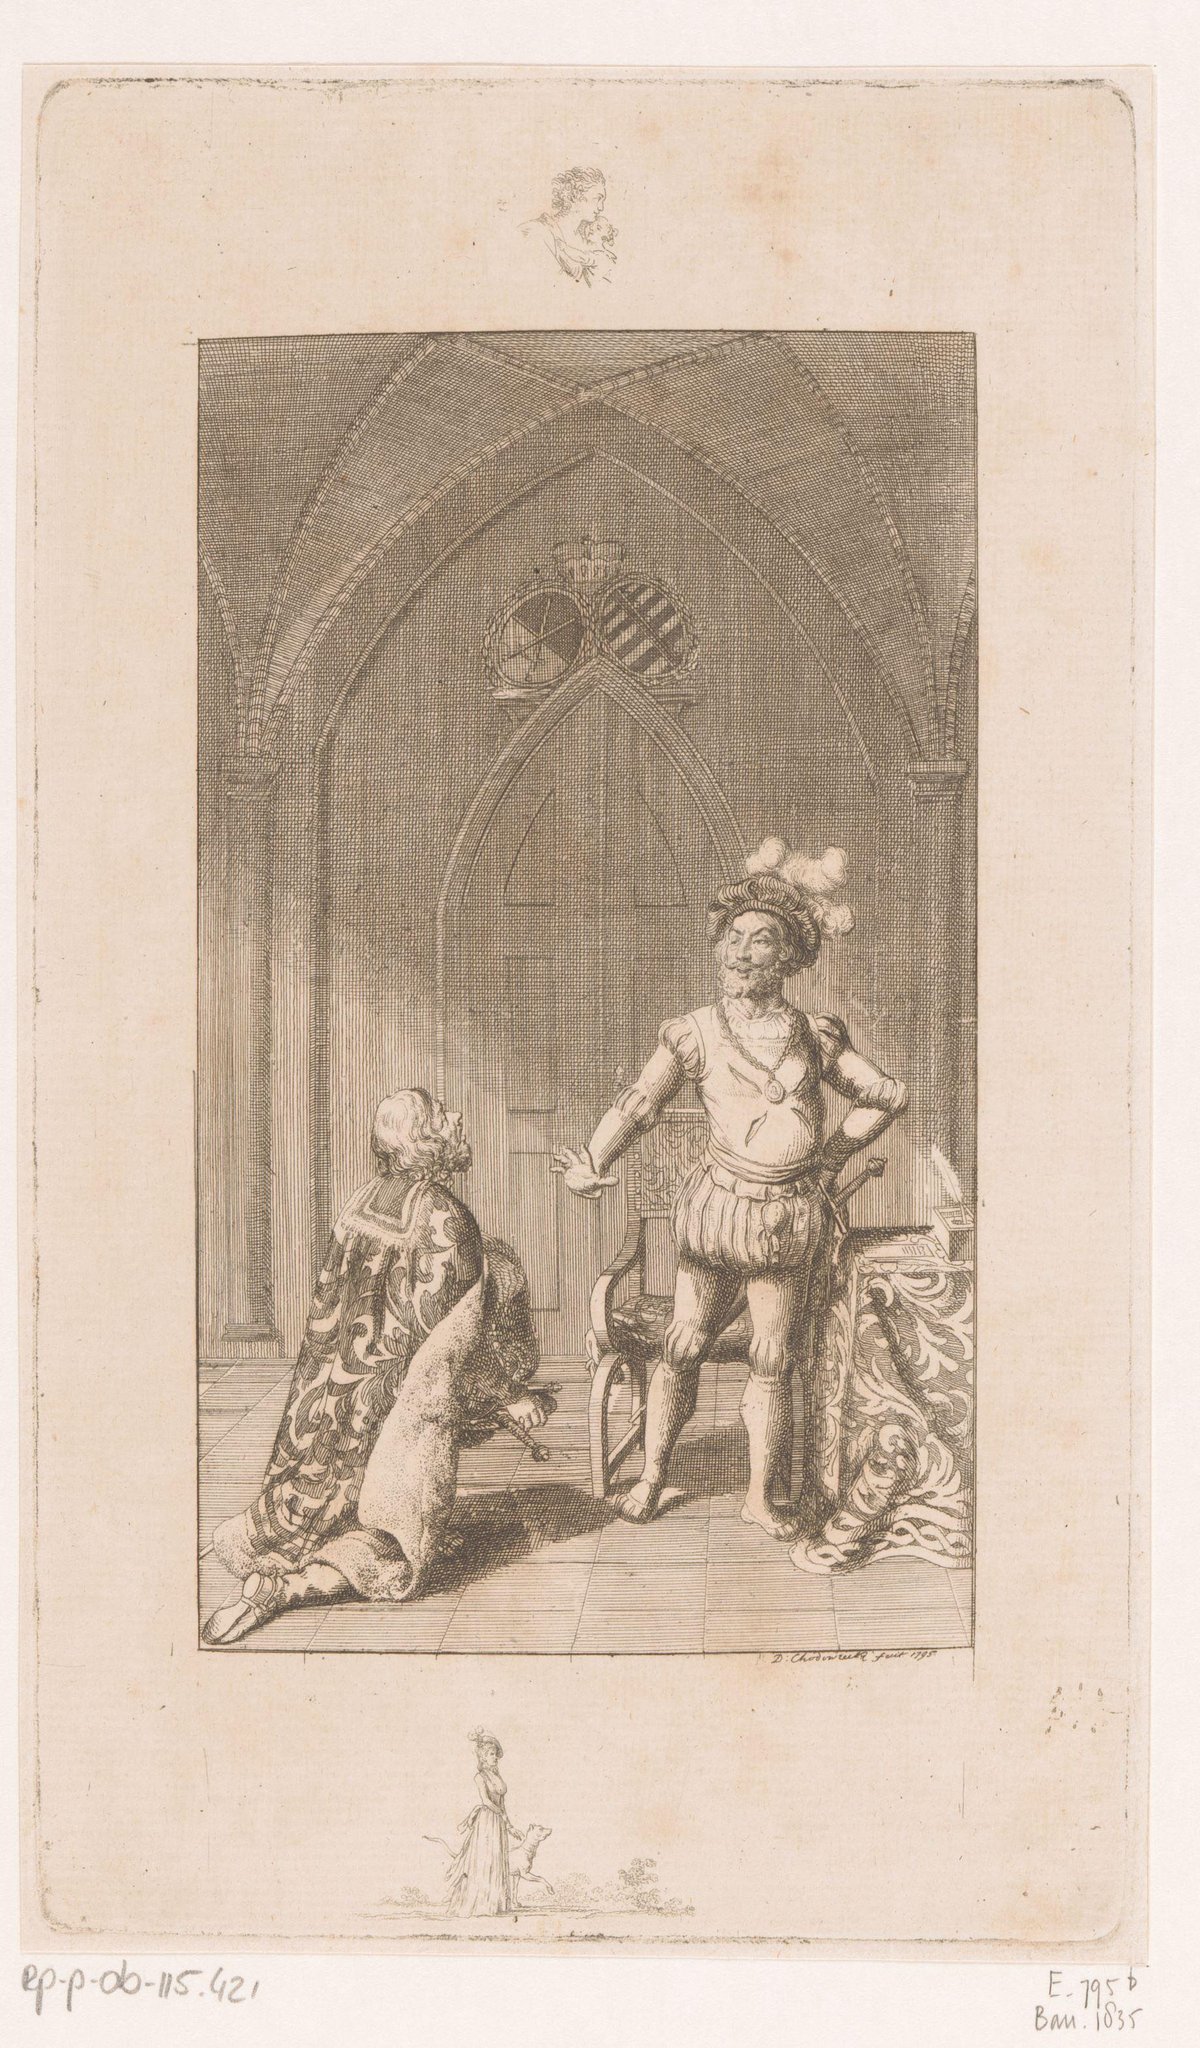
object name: print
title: Hendrik XIII ontvangt een ridder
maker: daniel nikolaus chodowiecki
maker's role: draughtsman, print maker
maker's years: 1726-1801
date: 1795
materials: paper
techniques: etching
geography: berlin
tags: history, ruler, sovereign, knight, armorial bearing, heraldry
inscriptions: collector's mark: Lugt 2228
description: Latere staat gebruikt voor: Deutsche Monatsschrift (...). 3 dln. Leipzig: Sommersche Buchhandlung, 1795.